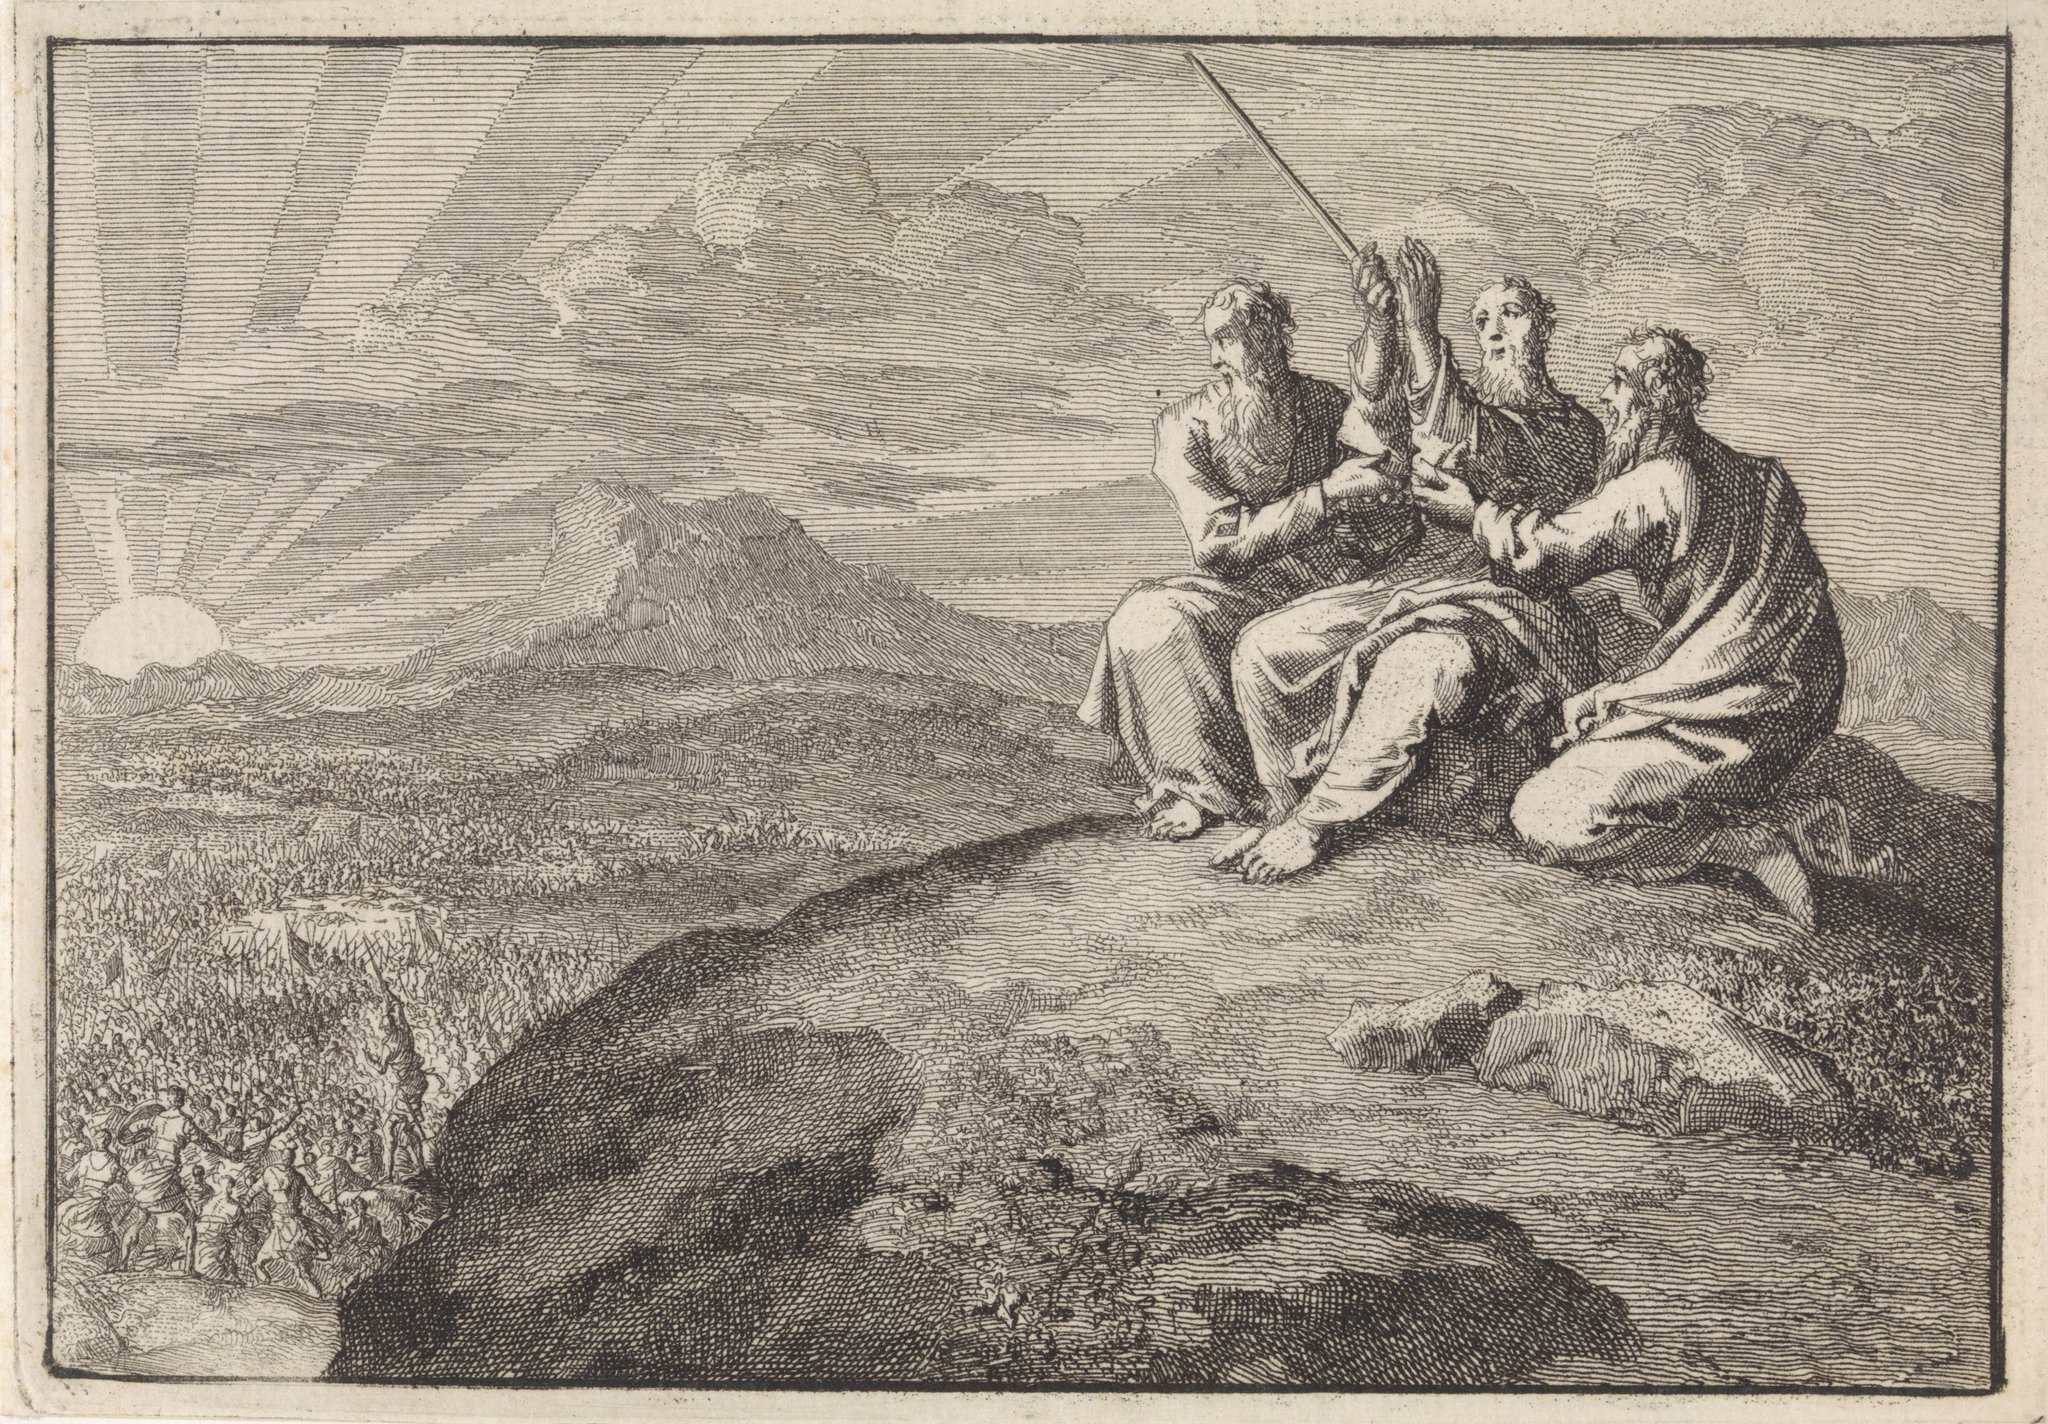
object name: print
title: Aäron en Chur stutten Mozes' handen tijdens de strijd van het volk Israël tegen de Amalekieten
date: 1703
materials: paper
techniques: etching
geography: amsterdam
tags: moses goes to the top of a hill with aaron and hur and raises his arms to make the israelites victorious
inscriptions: collector's mark: Lugt 2228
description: Proefdruk van een boekillustratie voor David Martin. Historie des Ouden en Nieuwen Testaments. Amsterdam, Pieter Mortier, 1703. Deel I. De boekillustraties voor de Mortierbijbel hebben verschillende staten en kopieën, waarbij de chronologische volgorde moeilijk te achterhalen valt. Als boekillustraties werden ze bovendien herhaaldelijk opnieuw gebruikt voor andere boekwerken.